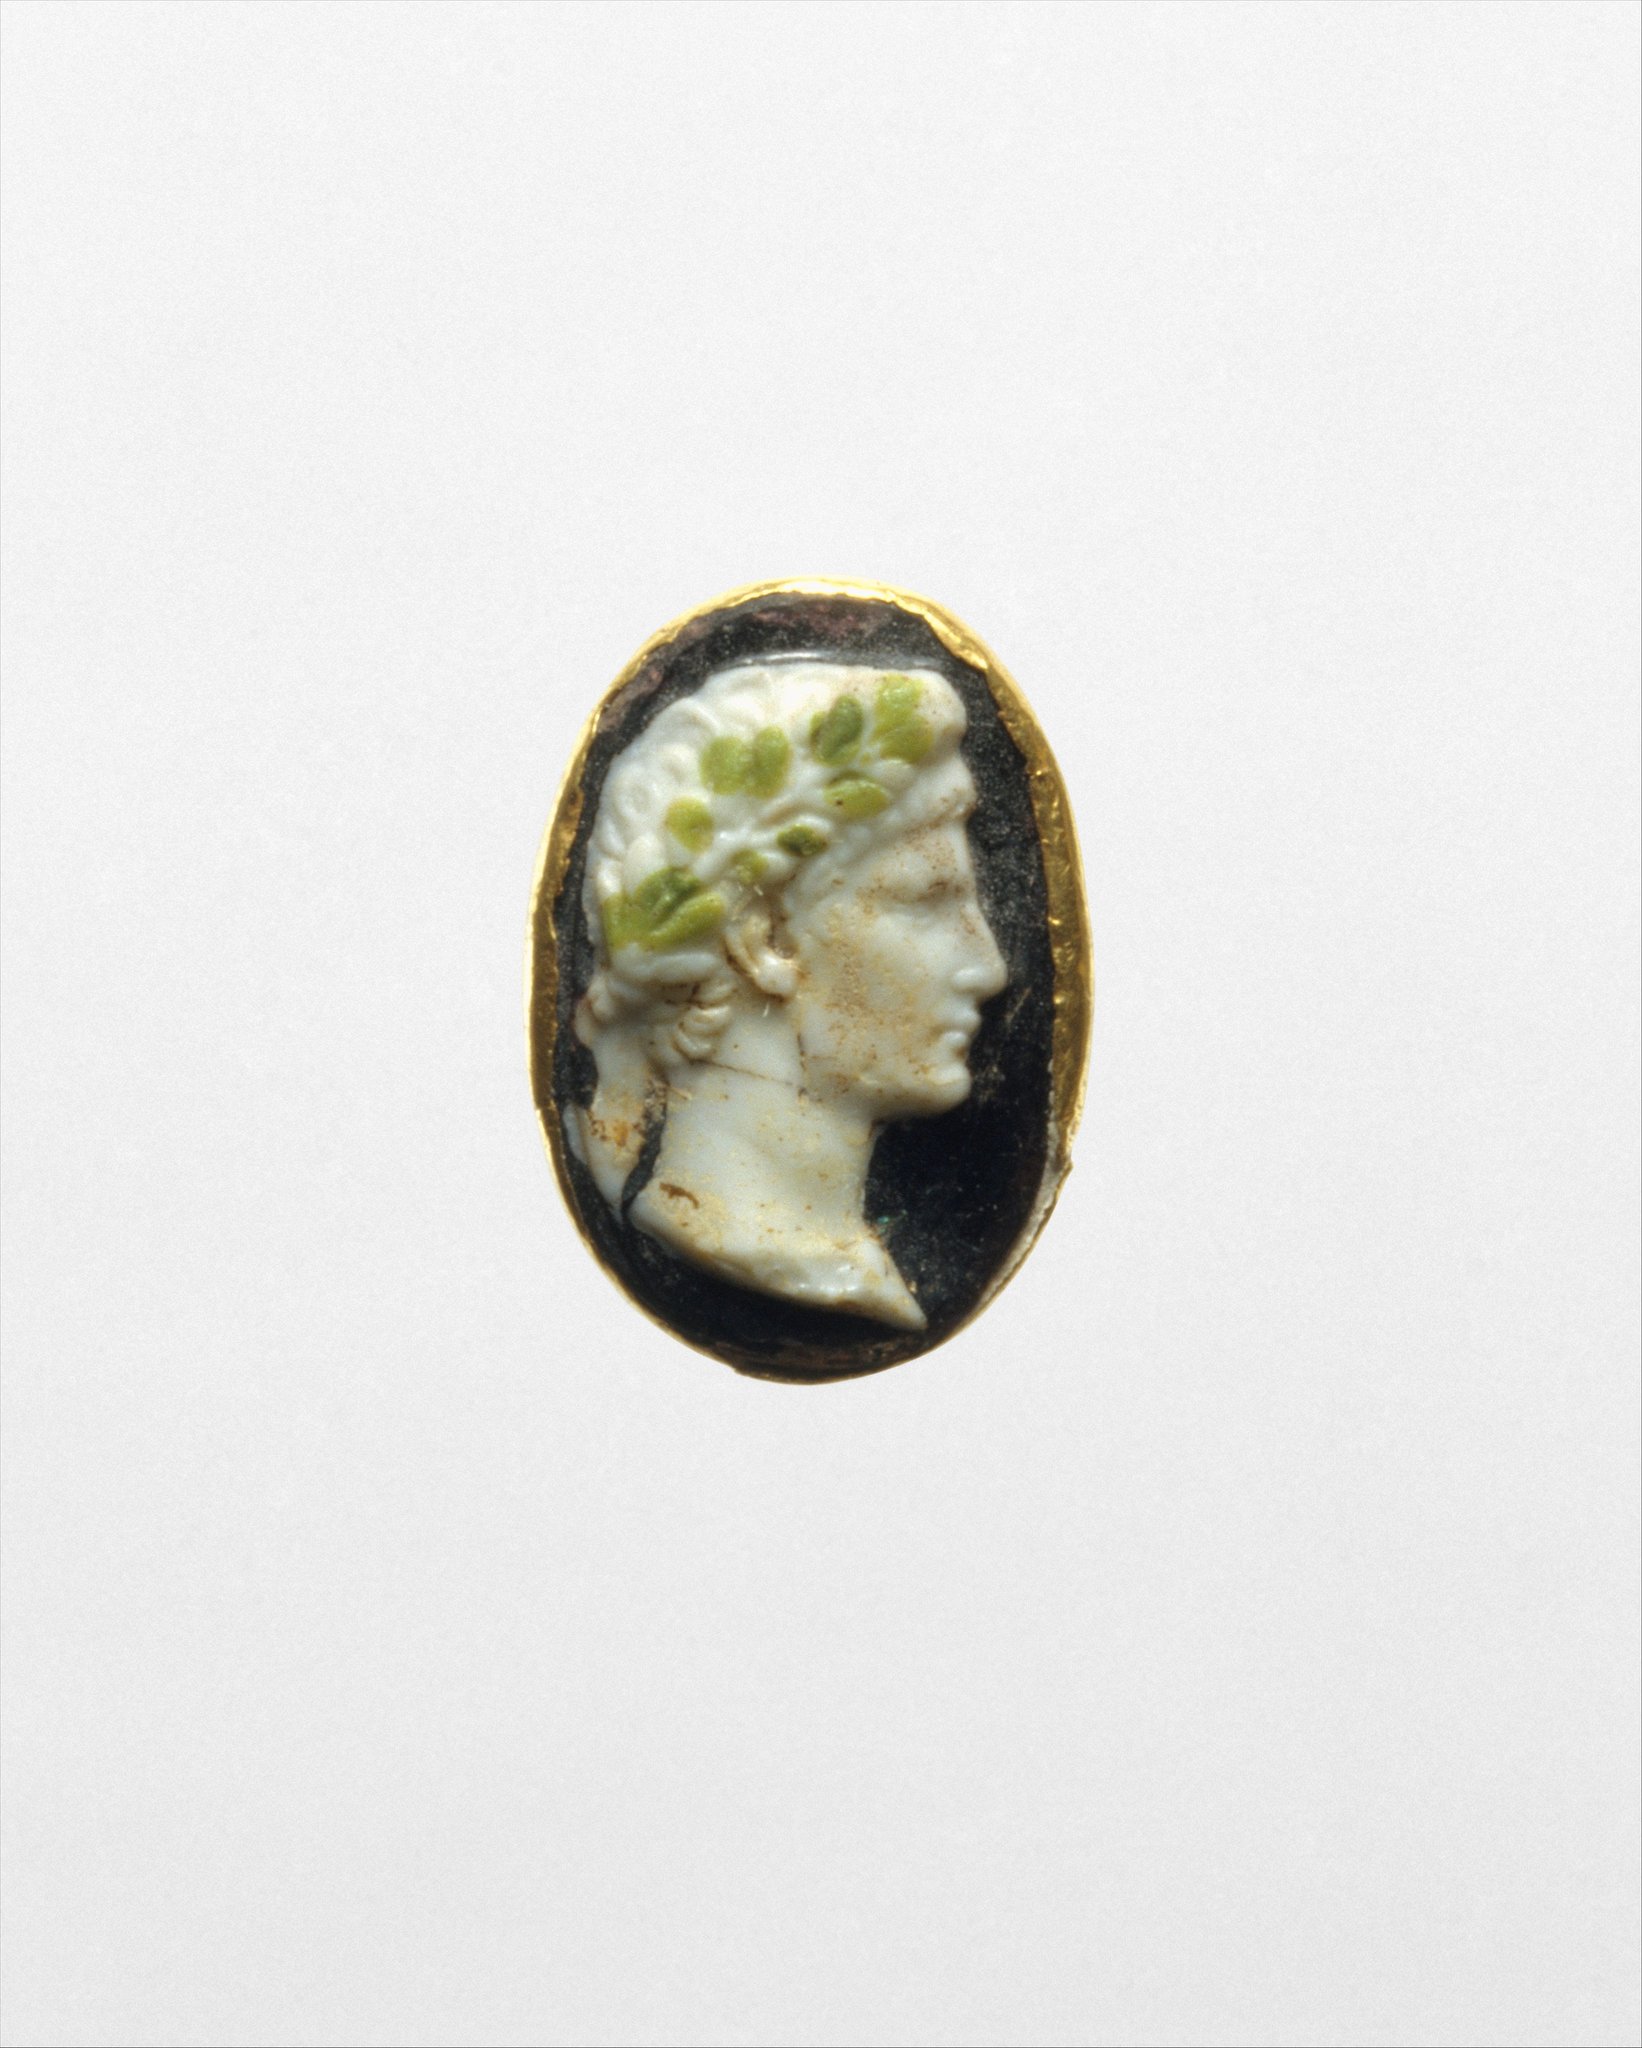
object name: ring with glass portrait of emperor augustus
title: Gold ring with cameo glass portrait of the Emperor Augustus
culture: roman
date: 1-50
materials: glass, gold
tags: emperor augustus,profiles